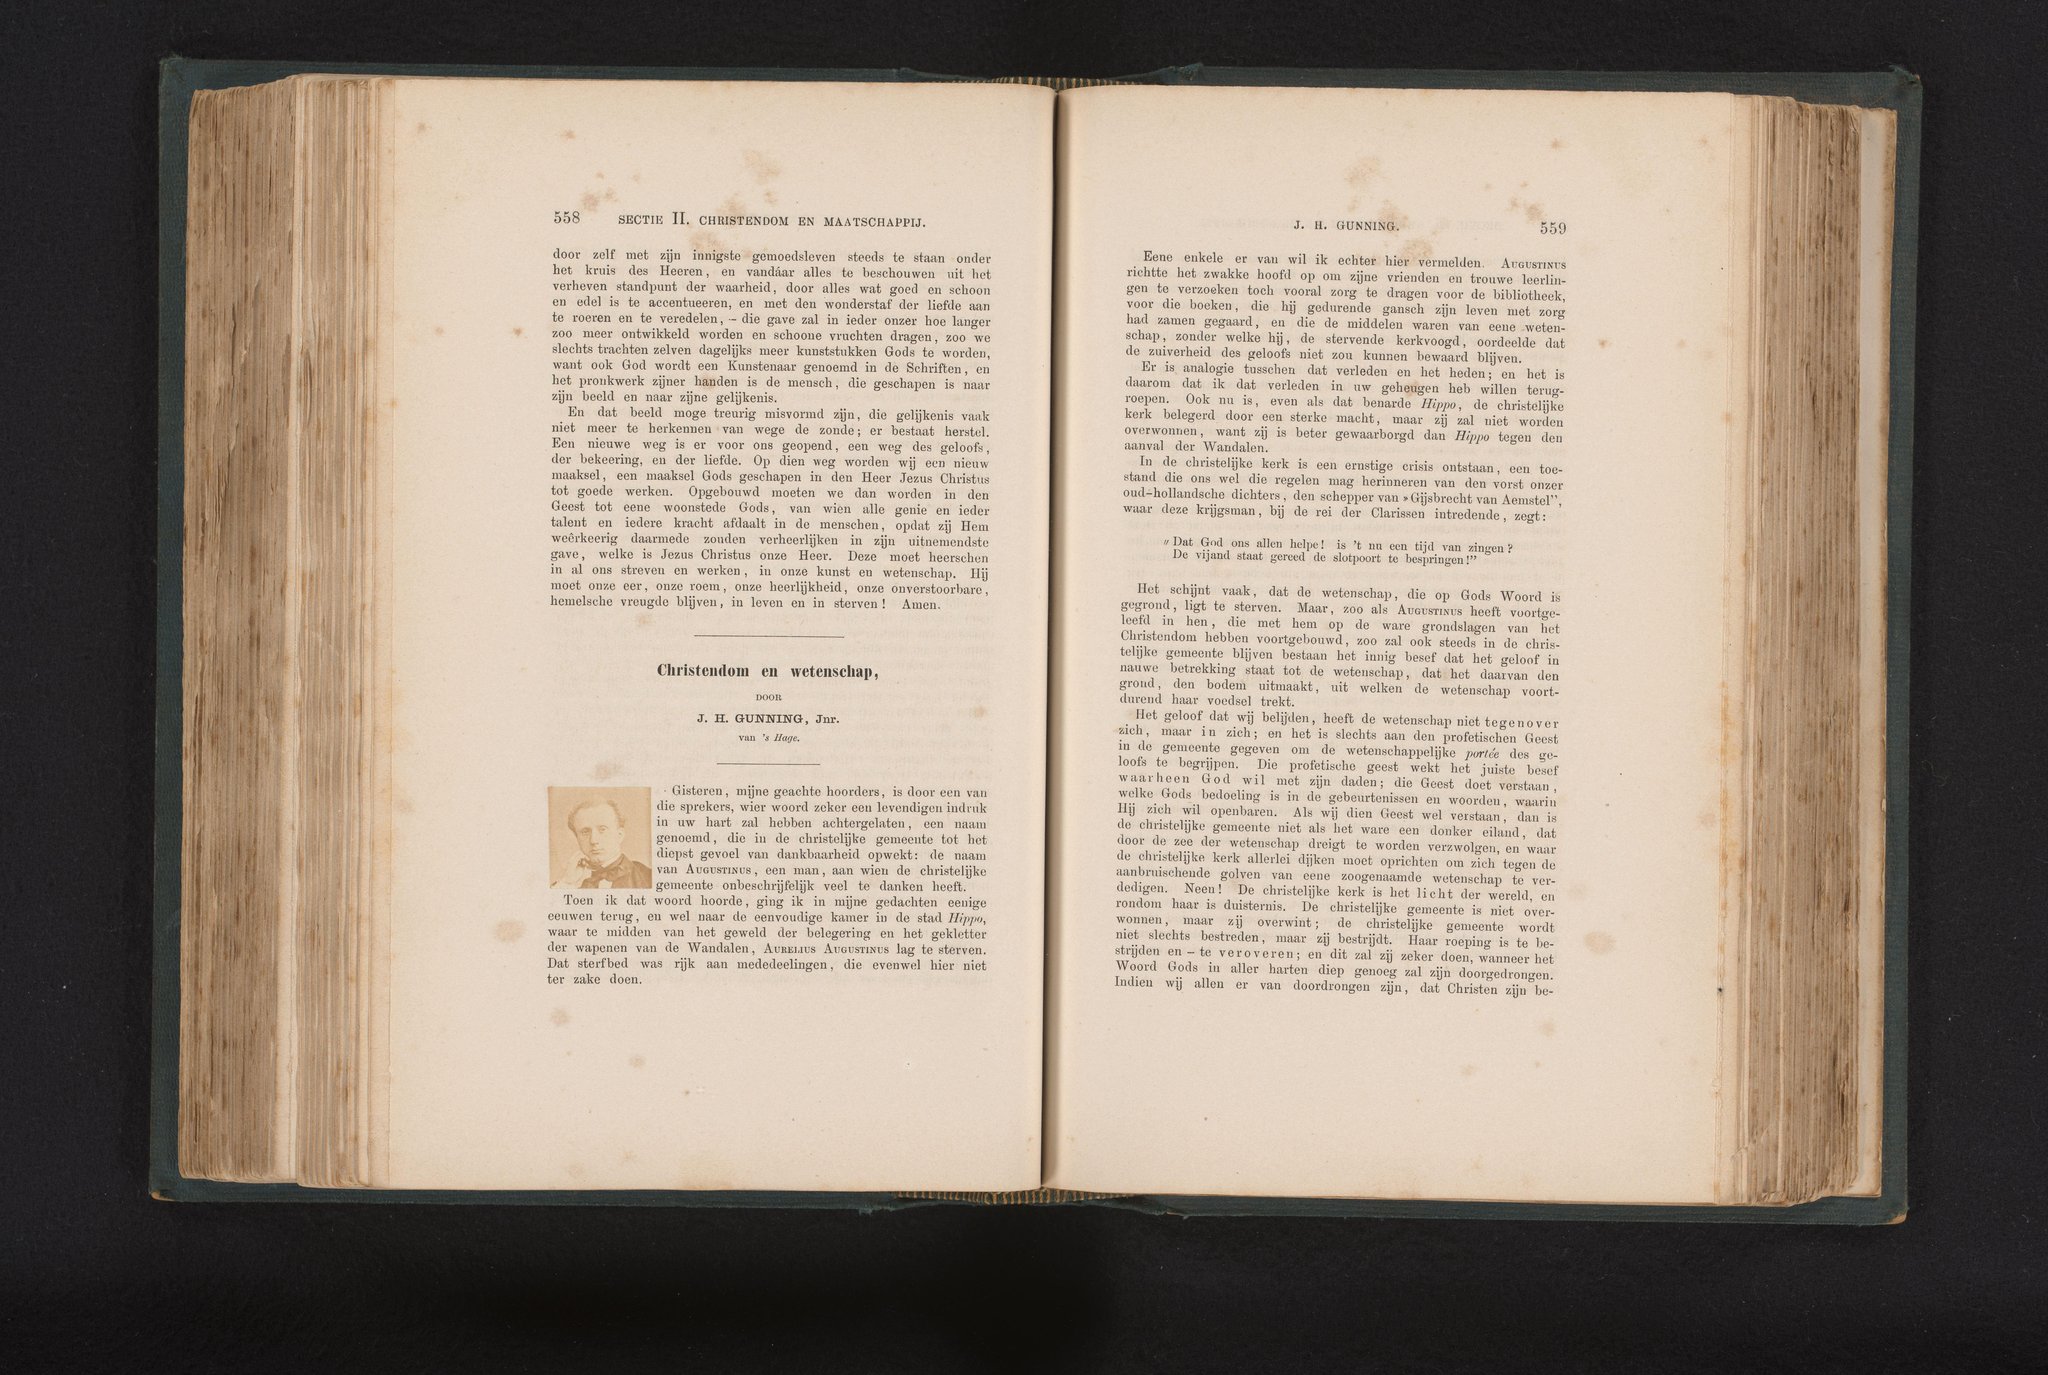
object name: photograph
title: Portret van J.H. Gunning jr.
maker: Anonymous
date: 1855-1867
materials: paper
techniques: albumen print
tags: historical persons